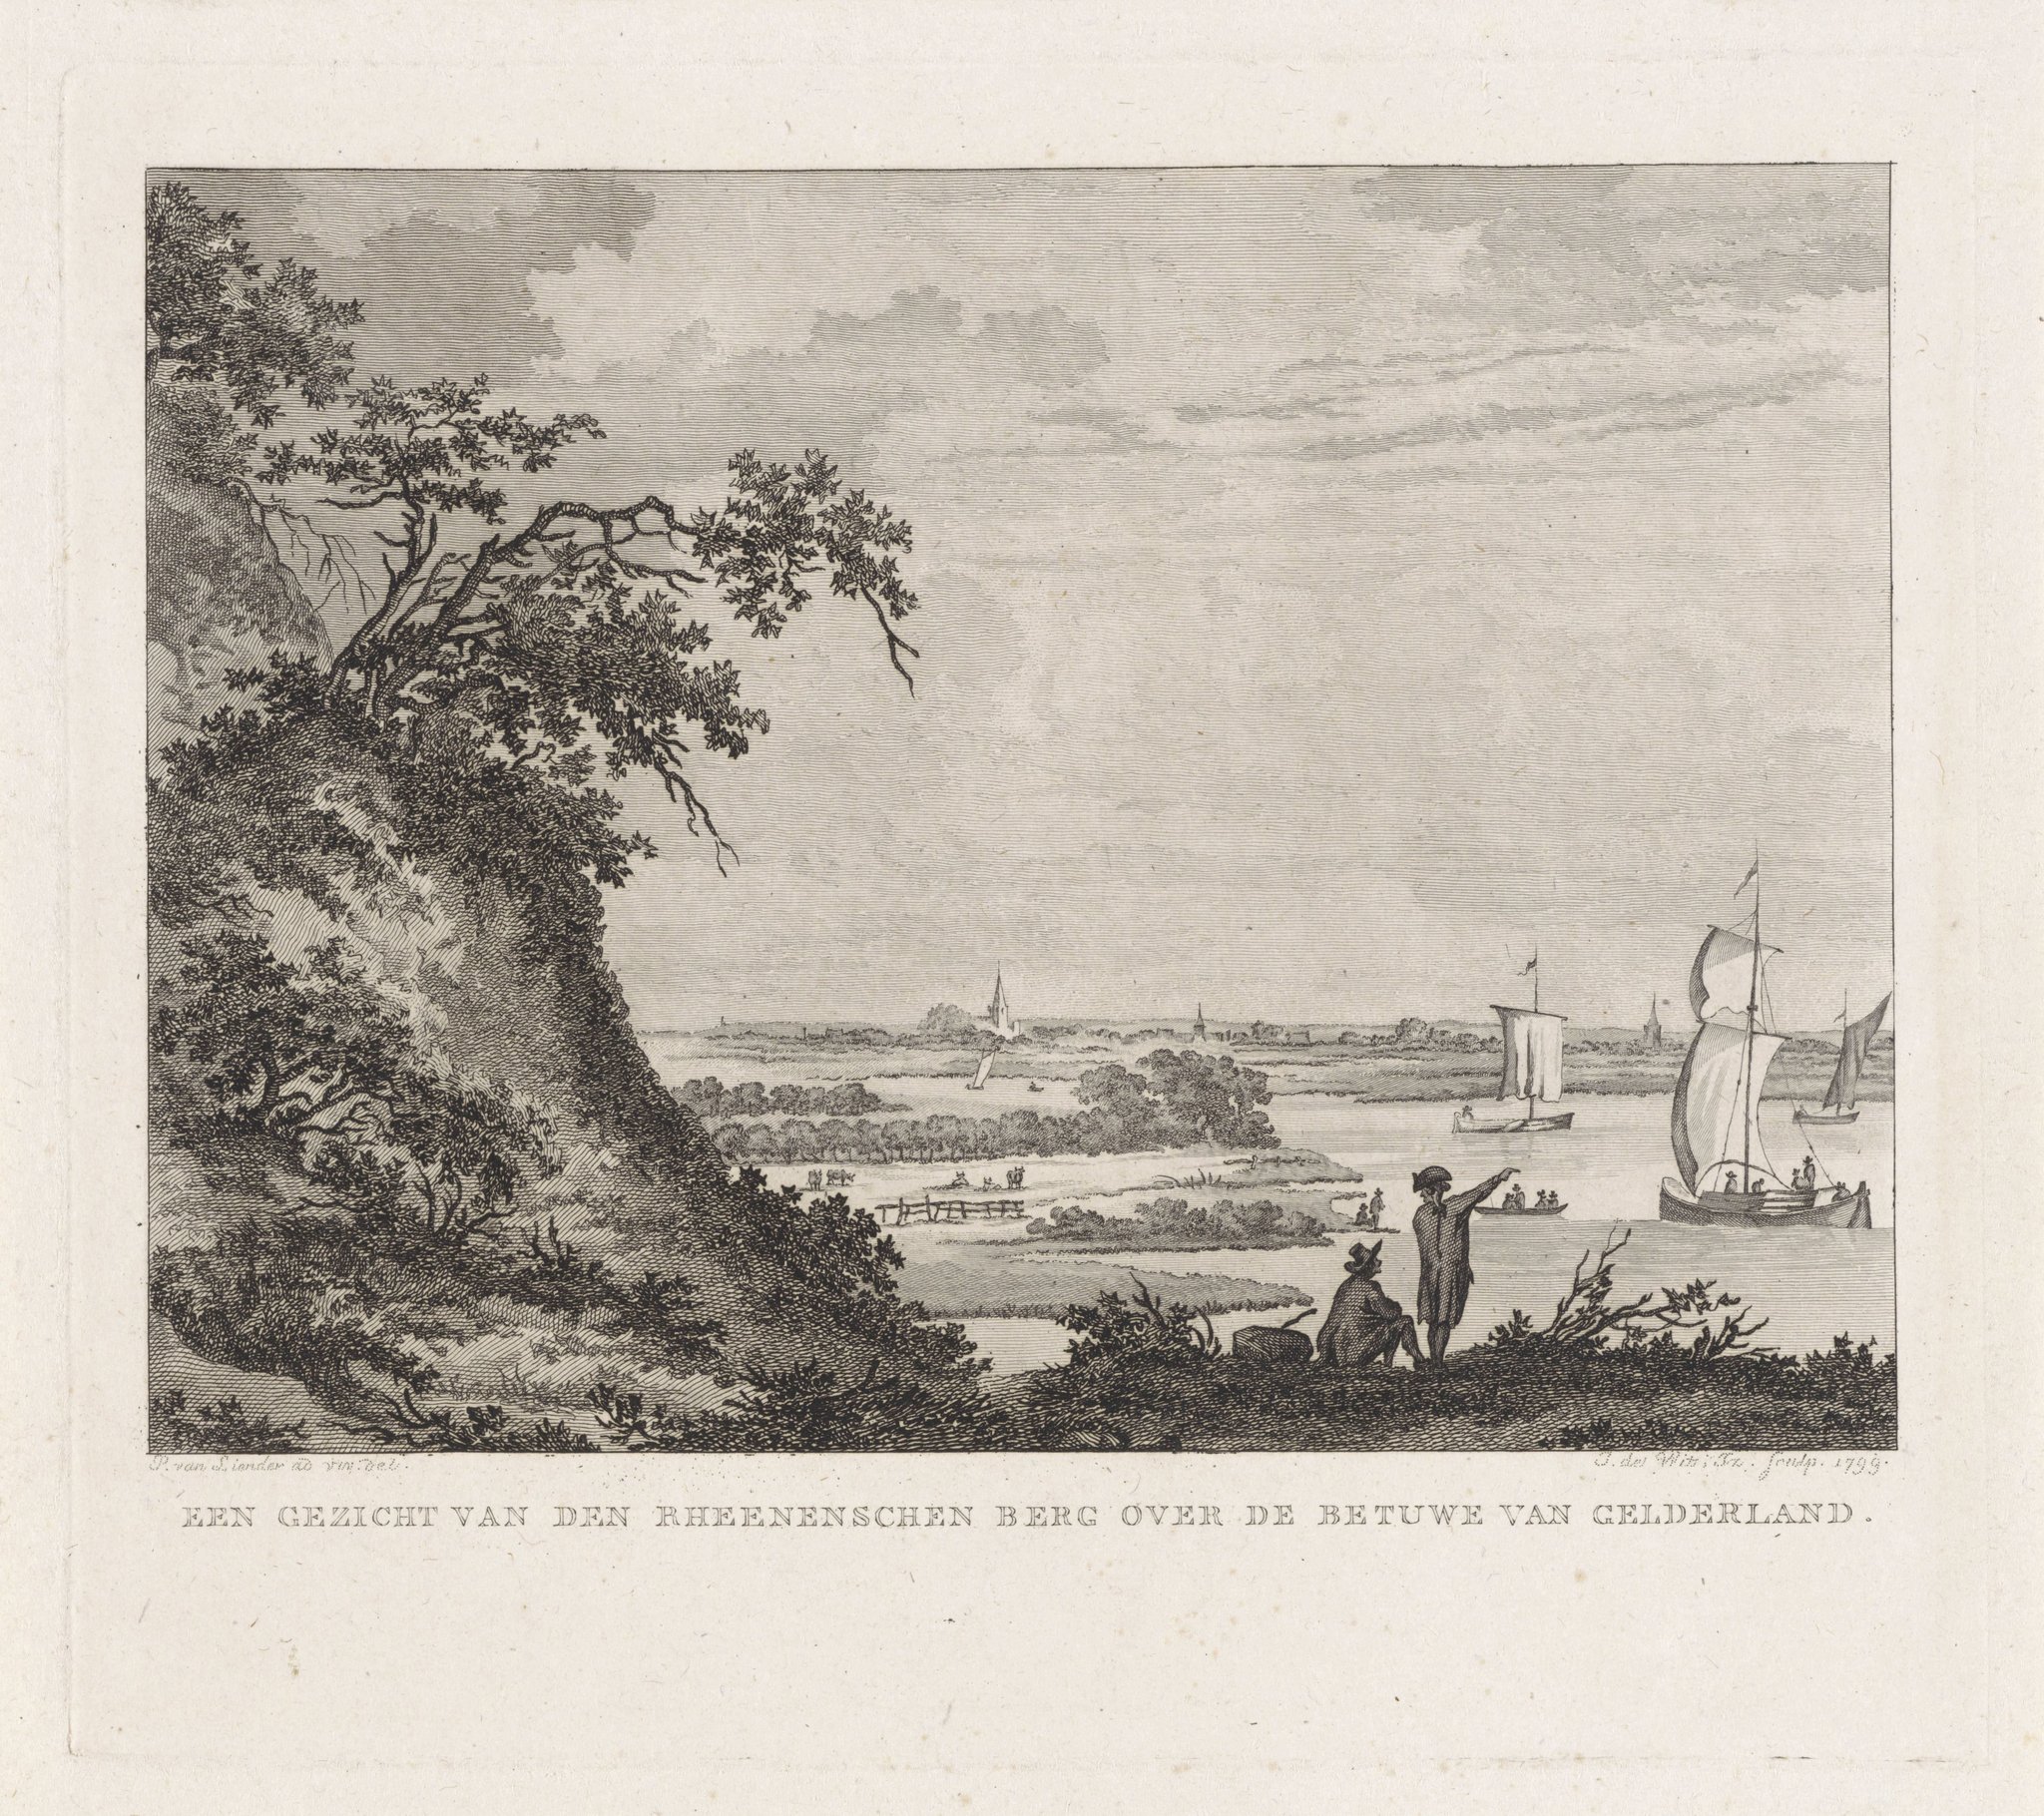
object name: print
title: Weids landschap met twee figuren en zeilschepen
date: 1799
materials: paper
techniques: etching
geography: haarlem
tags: sailing-ship, sailing-boat, water course, index finger forwards, pointing, indicating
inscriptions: collector's mark: Lugt 2228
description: Gezicht vanf de Rhenense berg over de Betuwe te Gelderland. Zeilschepen op het water en op de voorgrod twee figuren waarvan een wijst met uitgestrekte arm.